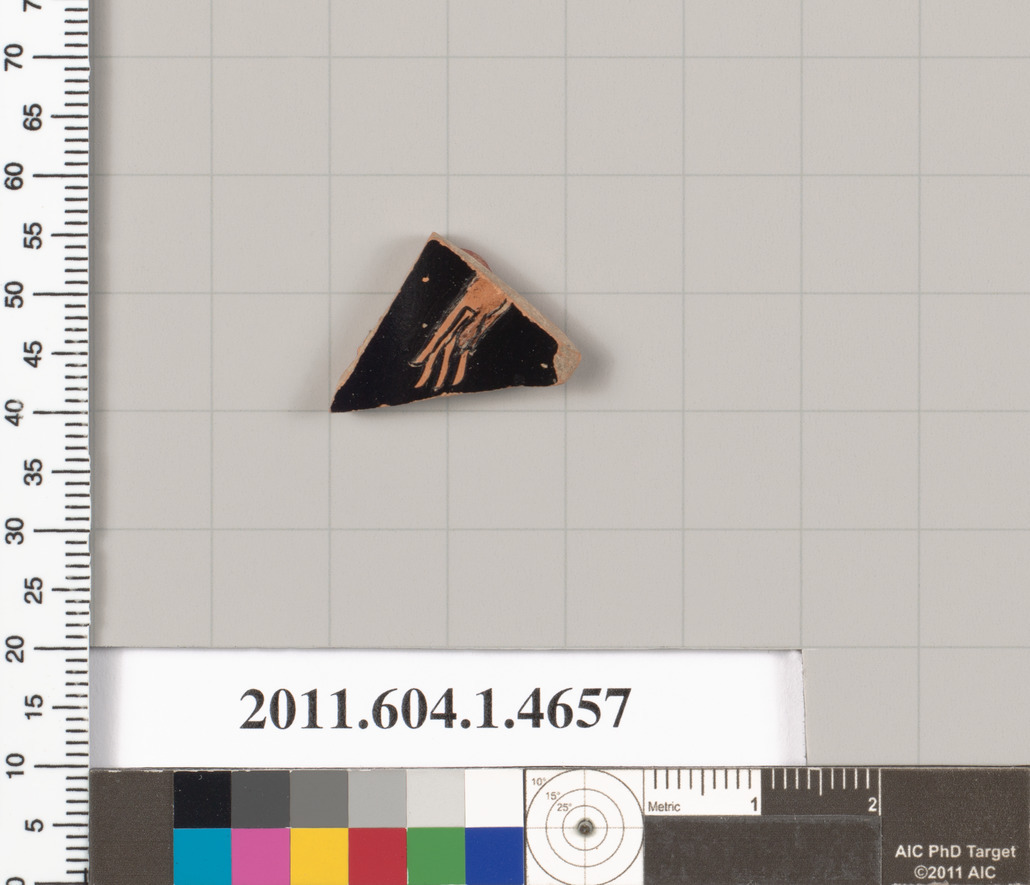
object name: kylix fragment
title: Terracotta fragment of a kylix (drinking cup)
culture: greek, attic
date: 520-500 BCE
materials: terracotta